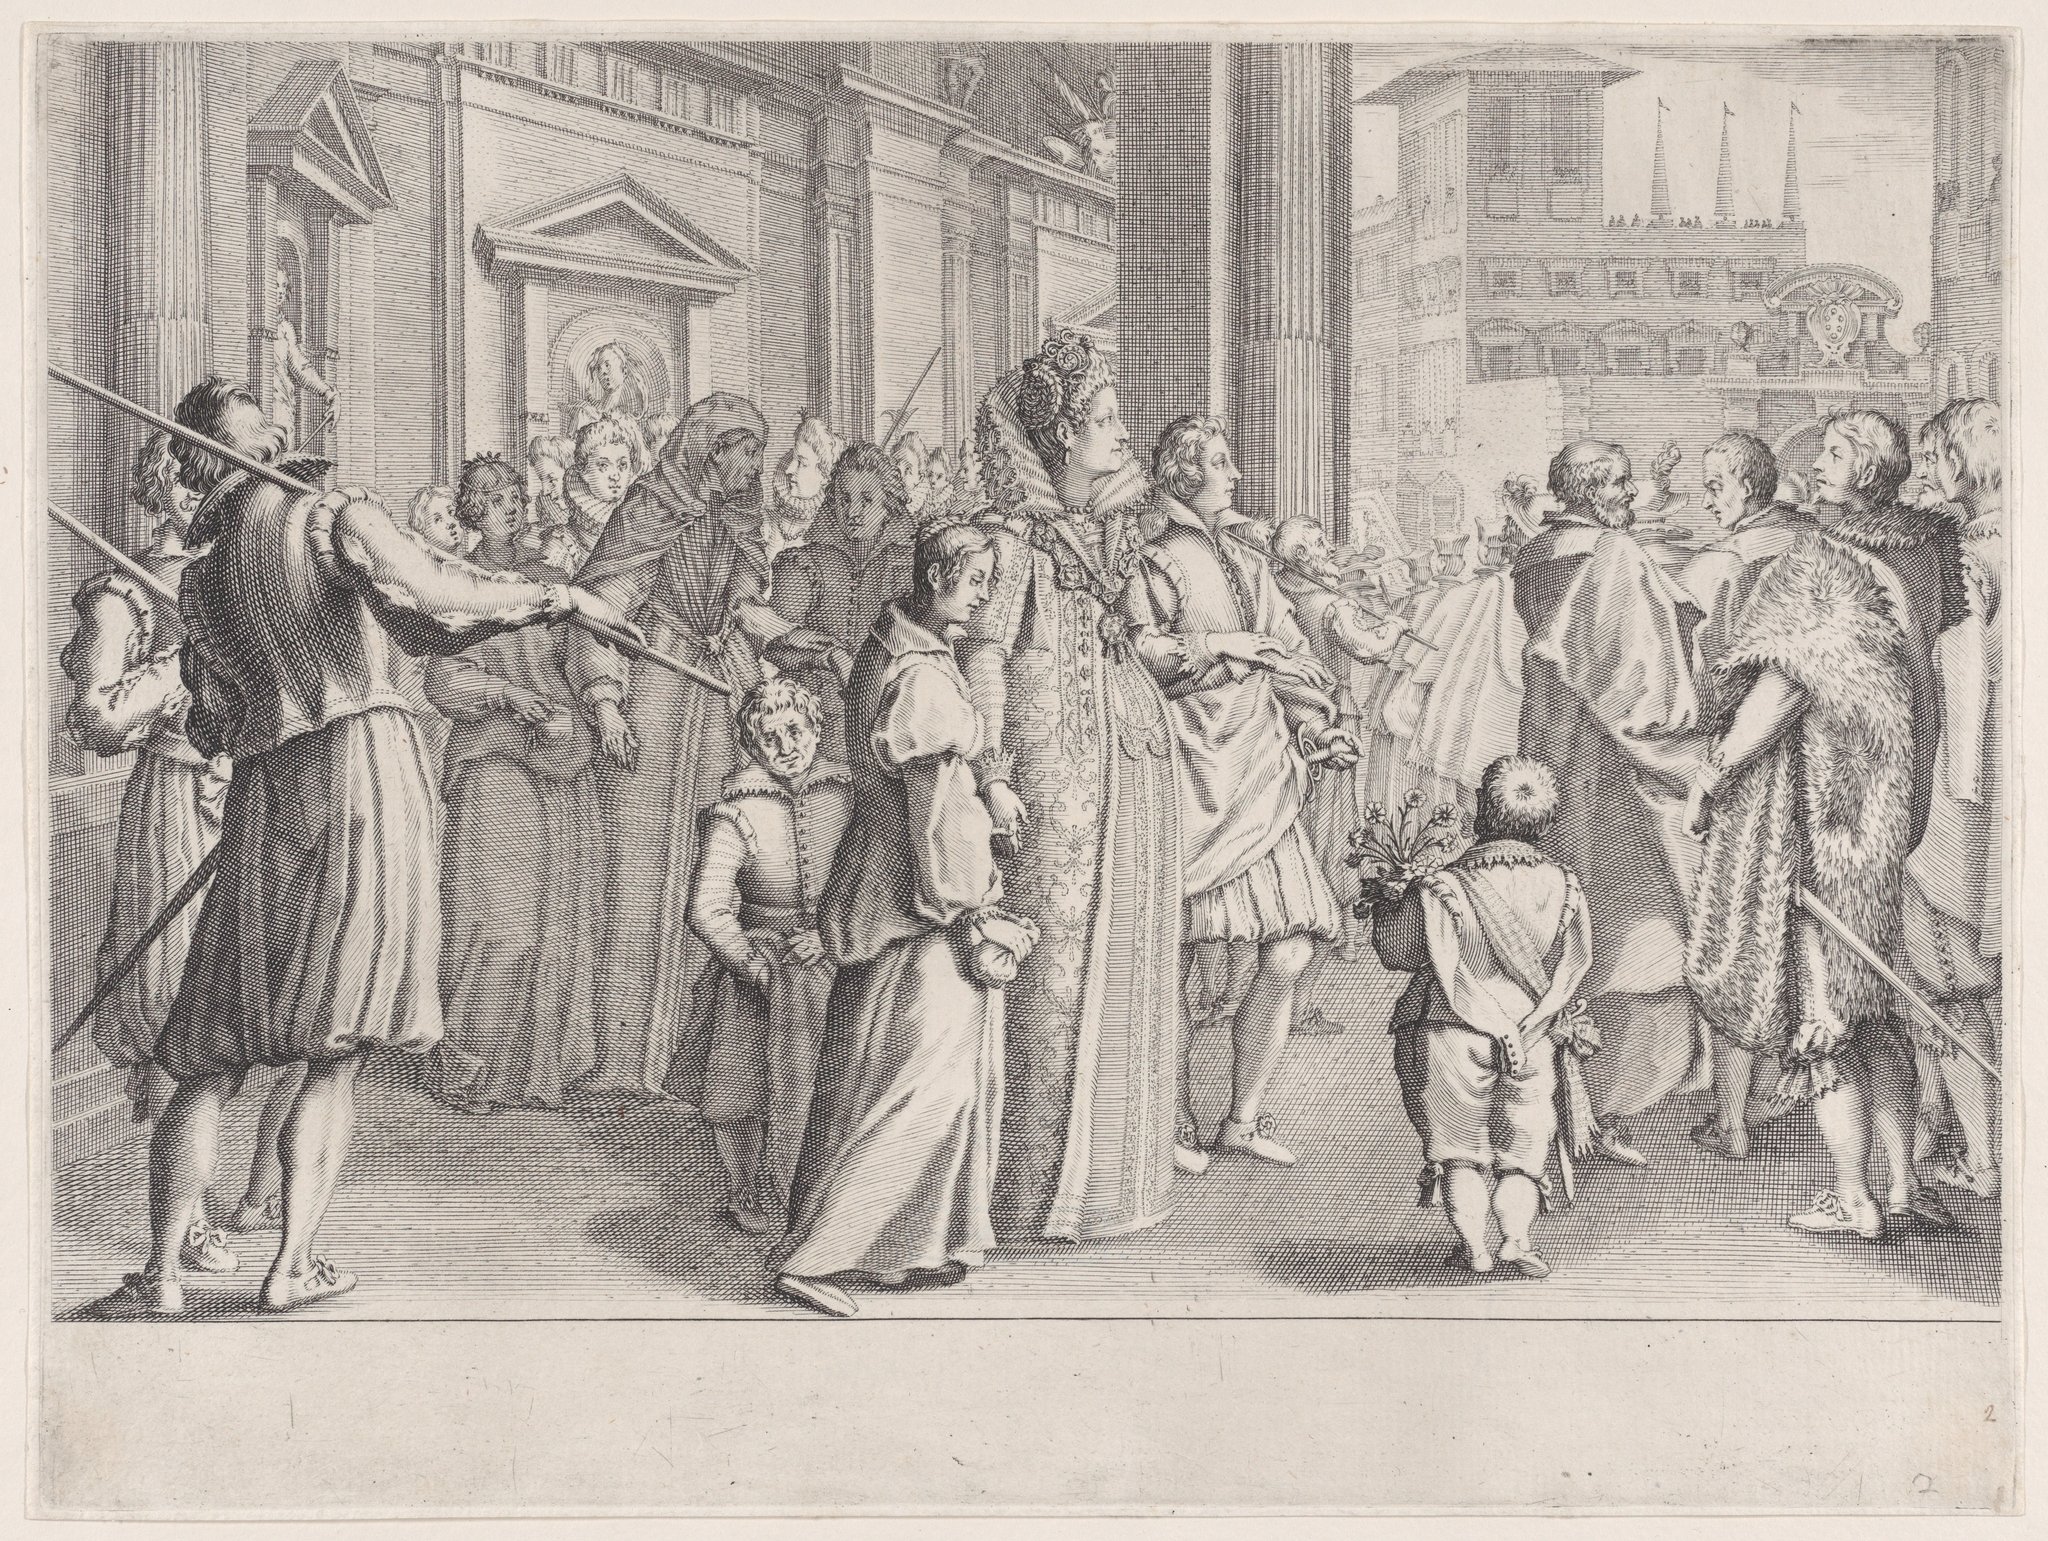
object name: print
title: La Grande Duchesse Marie des Jeunes Filles (The Great Duchess Marie des Jeunes Filles), from "La Vie de Ferdinand Ier de Médicis série appelée aussi Les Batailles des Médicis" (The Life of Ferdinand I de'Medici also called The Medici Battles)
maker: jacques callot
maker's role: artist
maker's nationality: french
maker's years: 1592-1635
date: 1614-1620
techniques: engraving